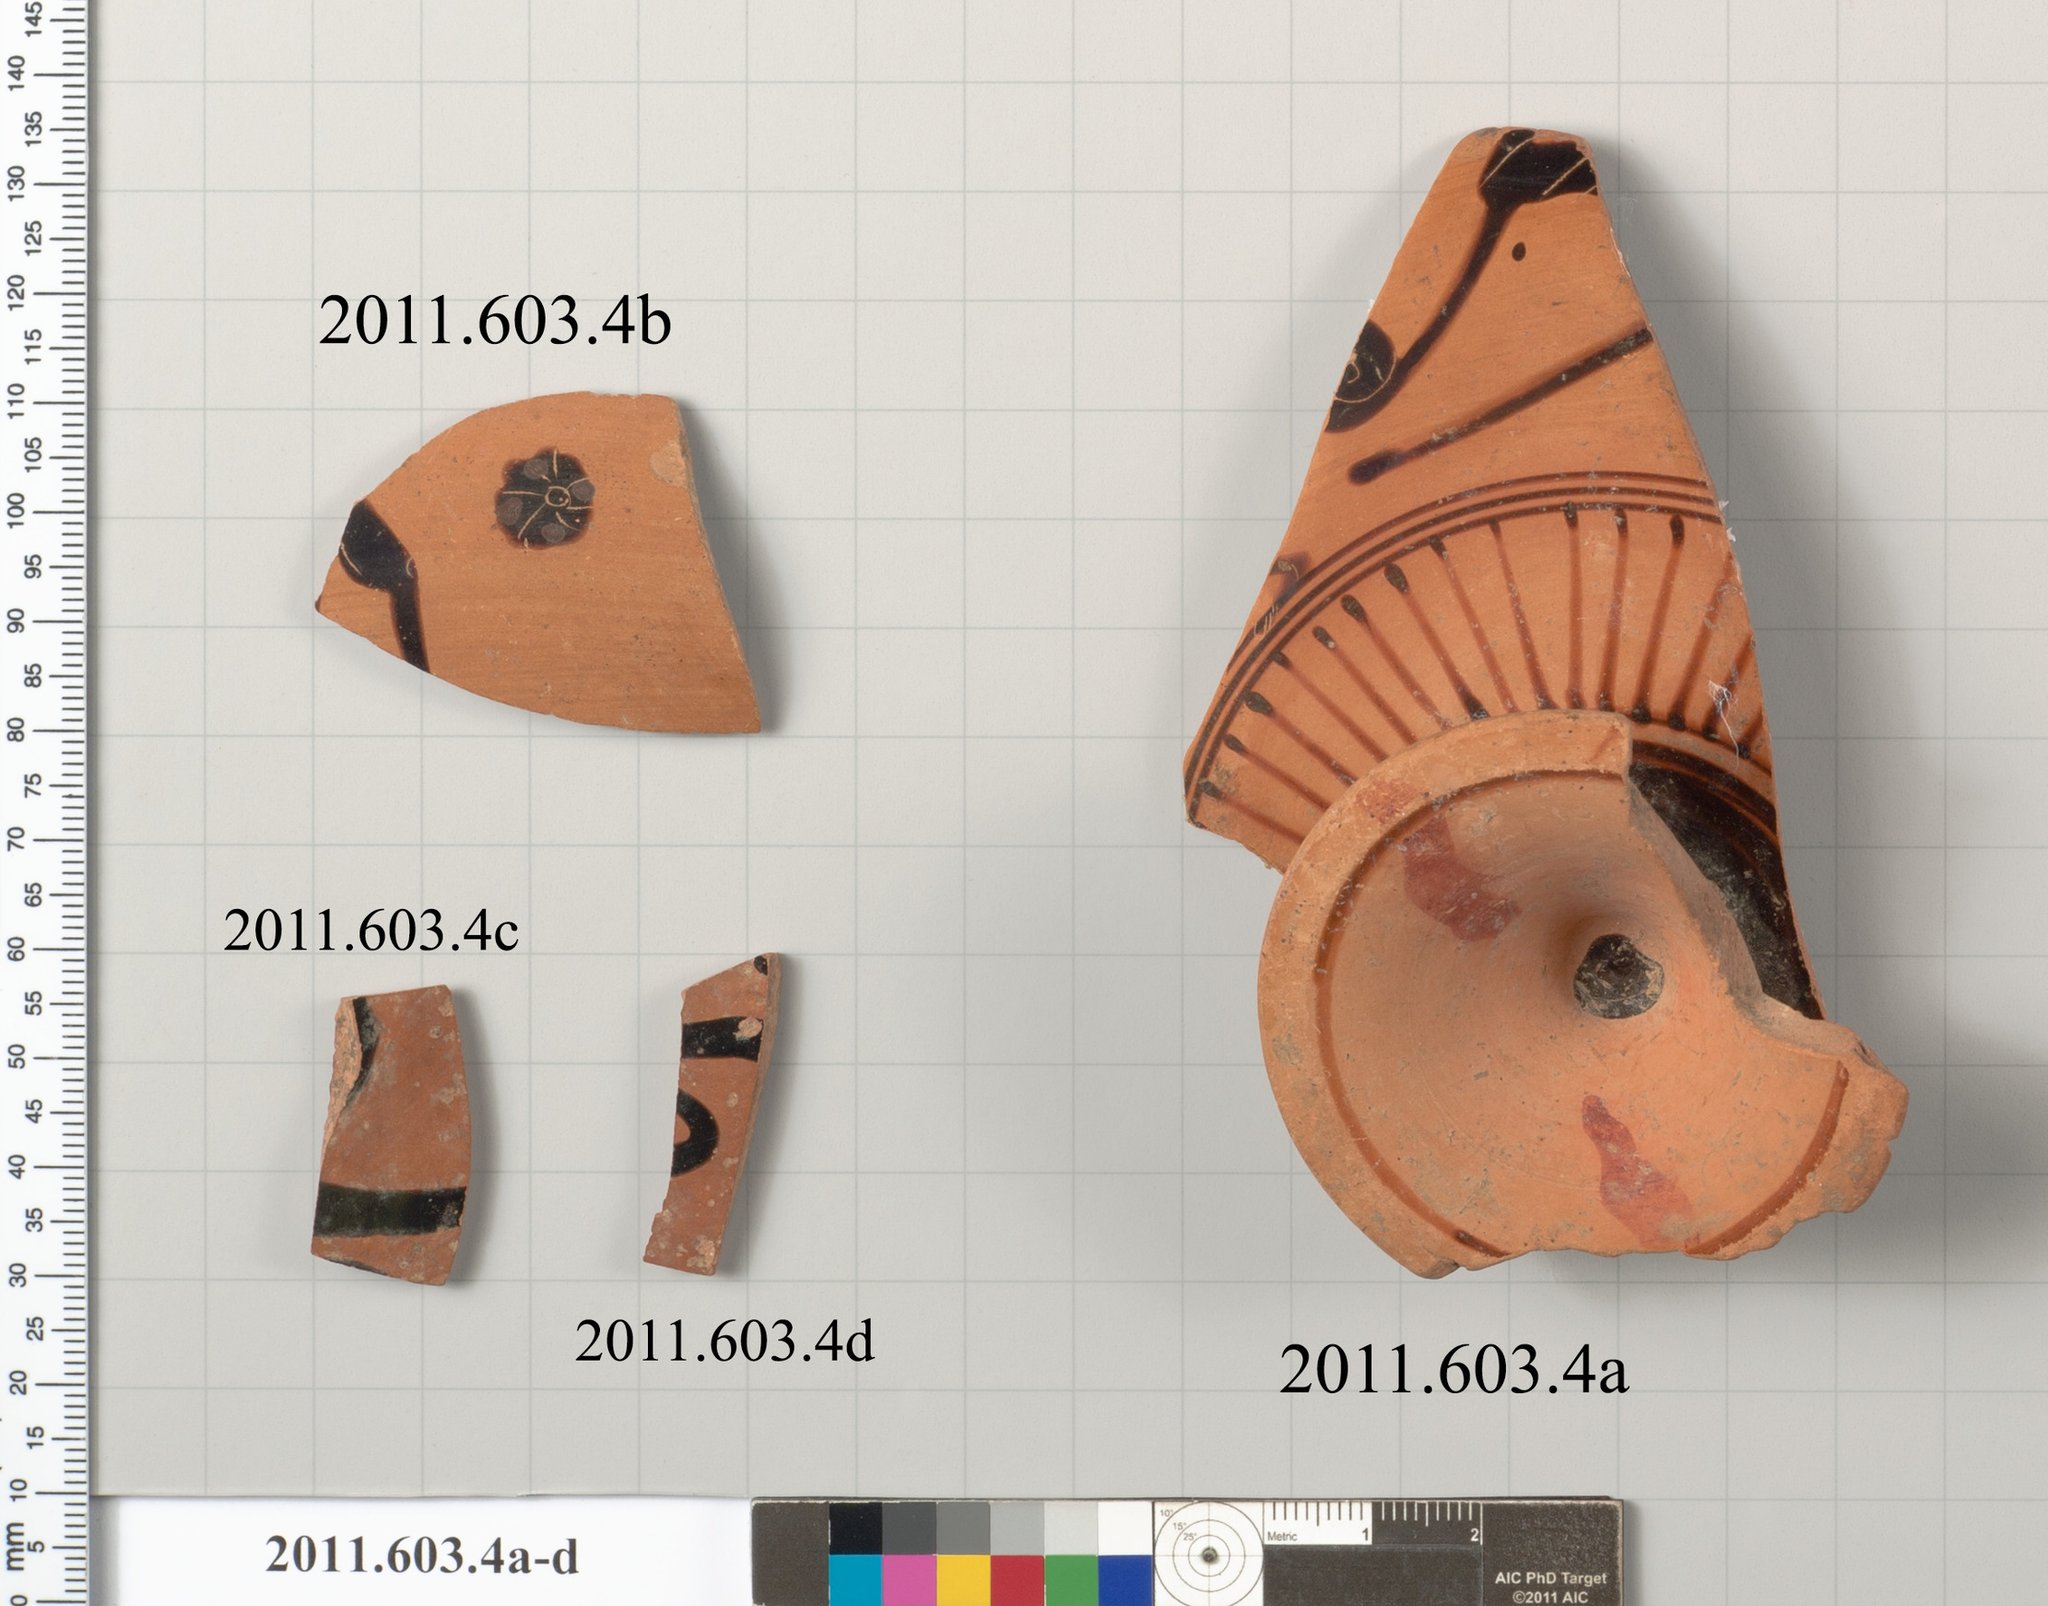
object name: kylix fragment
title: Fragments of a terracotta kylix: Komast cup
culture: greek, attic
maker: falmouth painter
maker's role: artist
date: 570 BCE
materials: terracotta